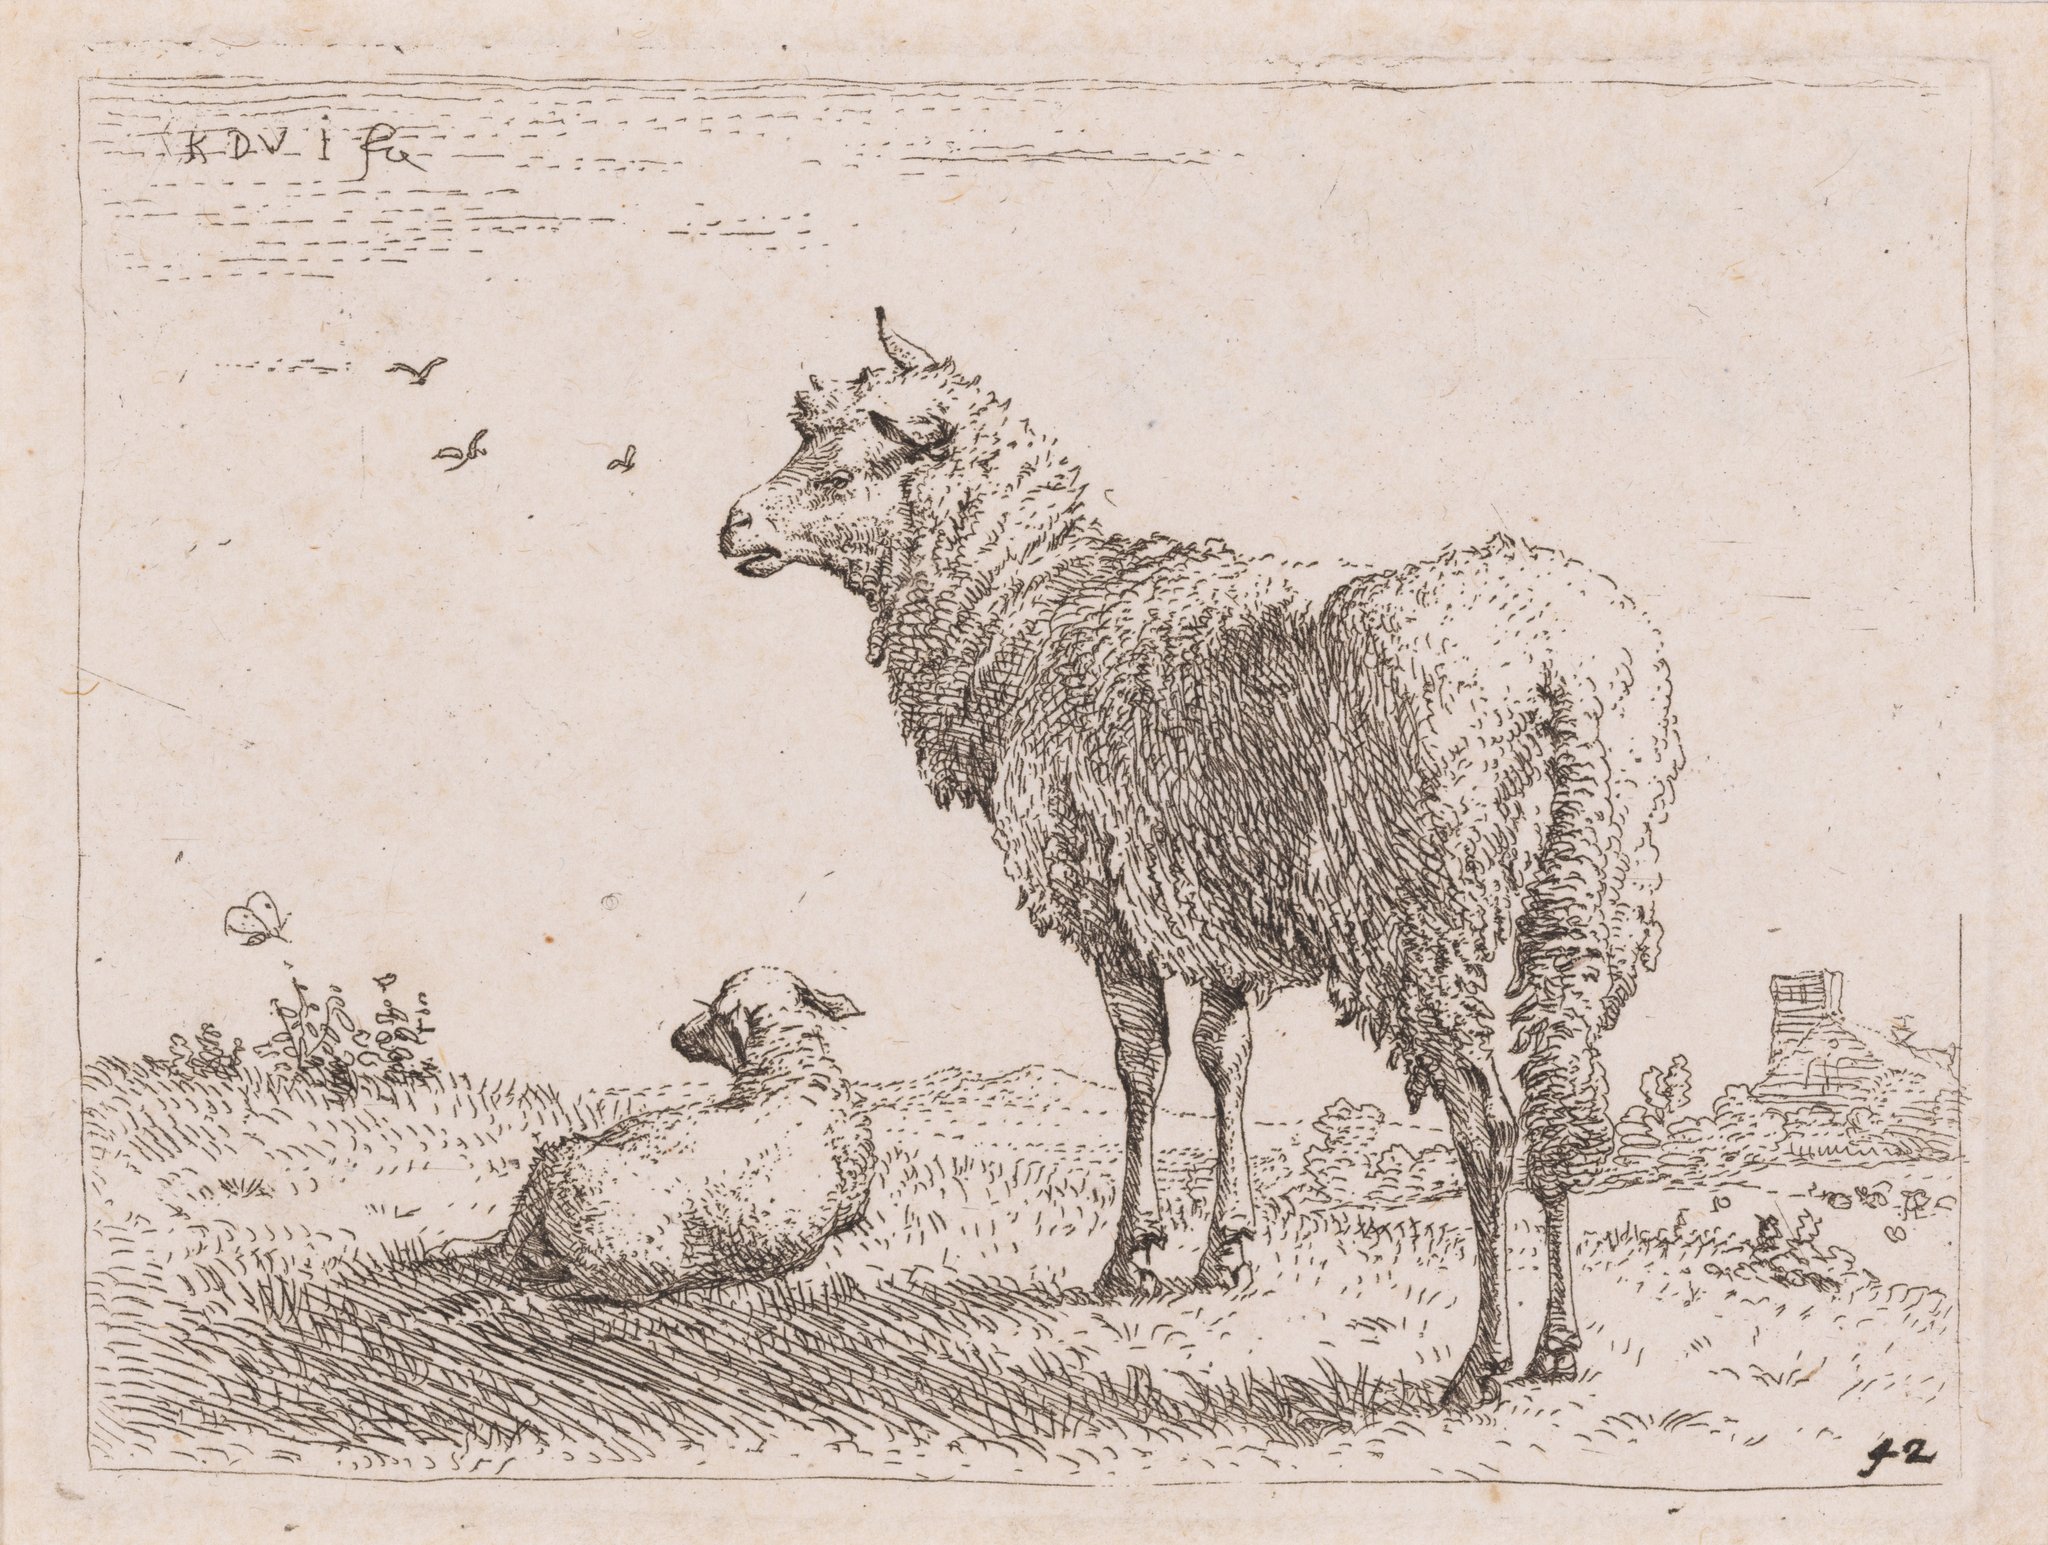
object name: print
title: Ewe and Lamb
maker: karel dujardin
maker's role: artist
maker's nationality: dutch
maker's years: 1622-1678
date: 1641-1678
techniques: etching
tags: sheep